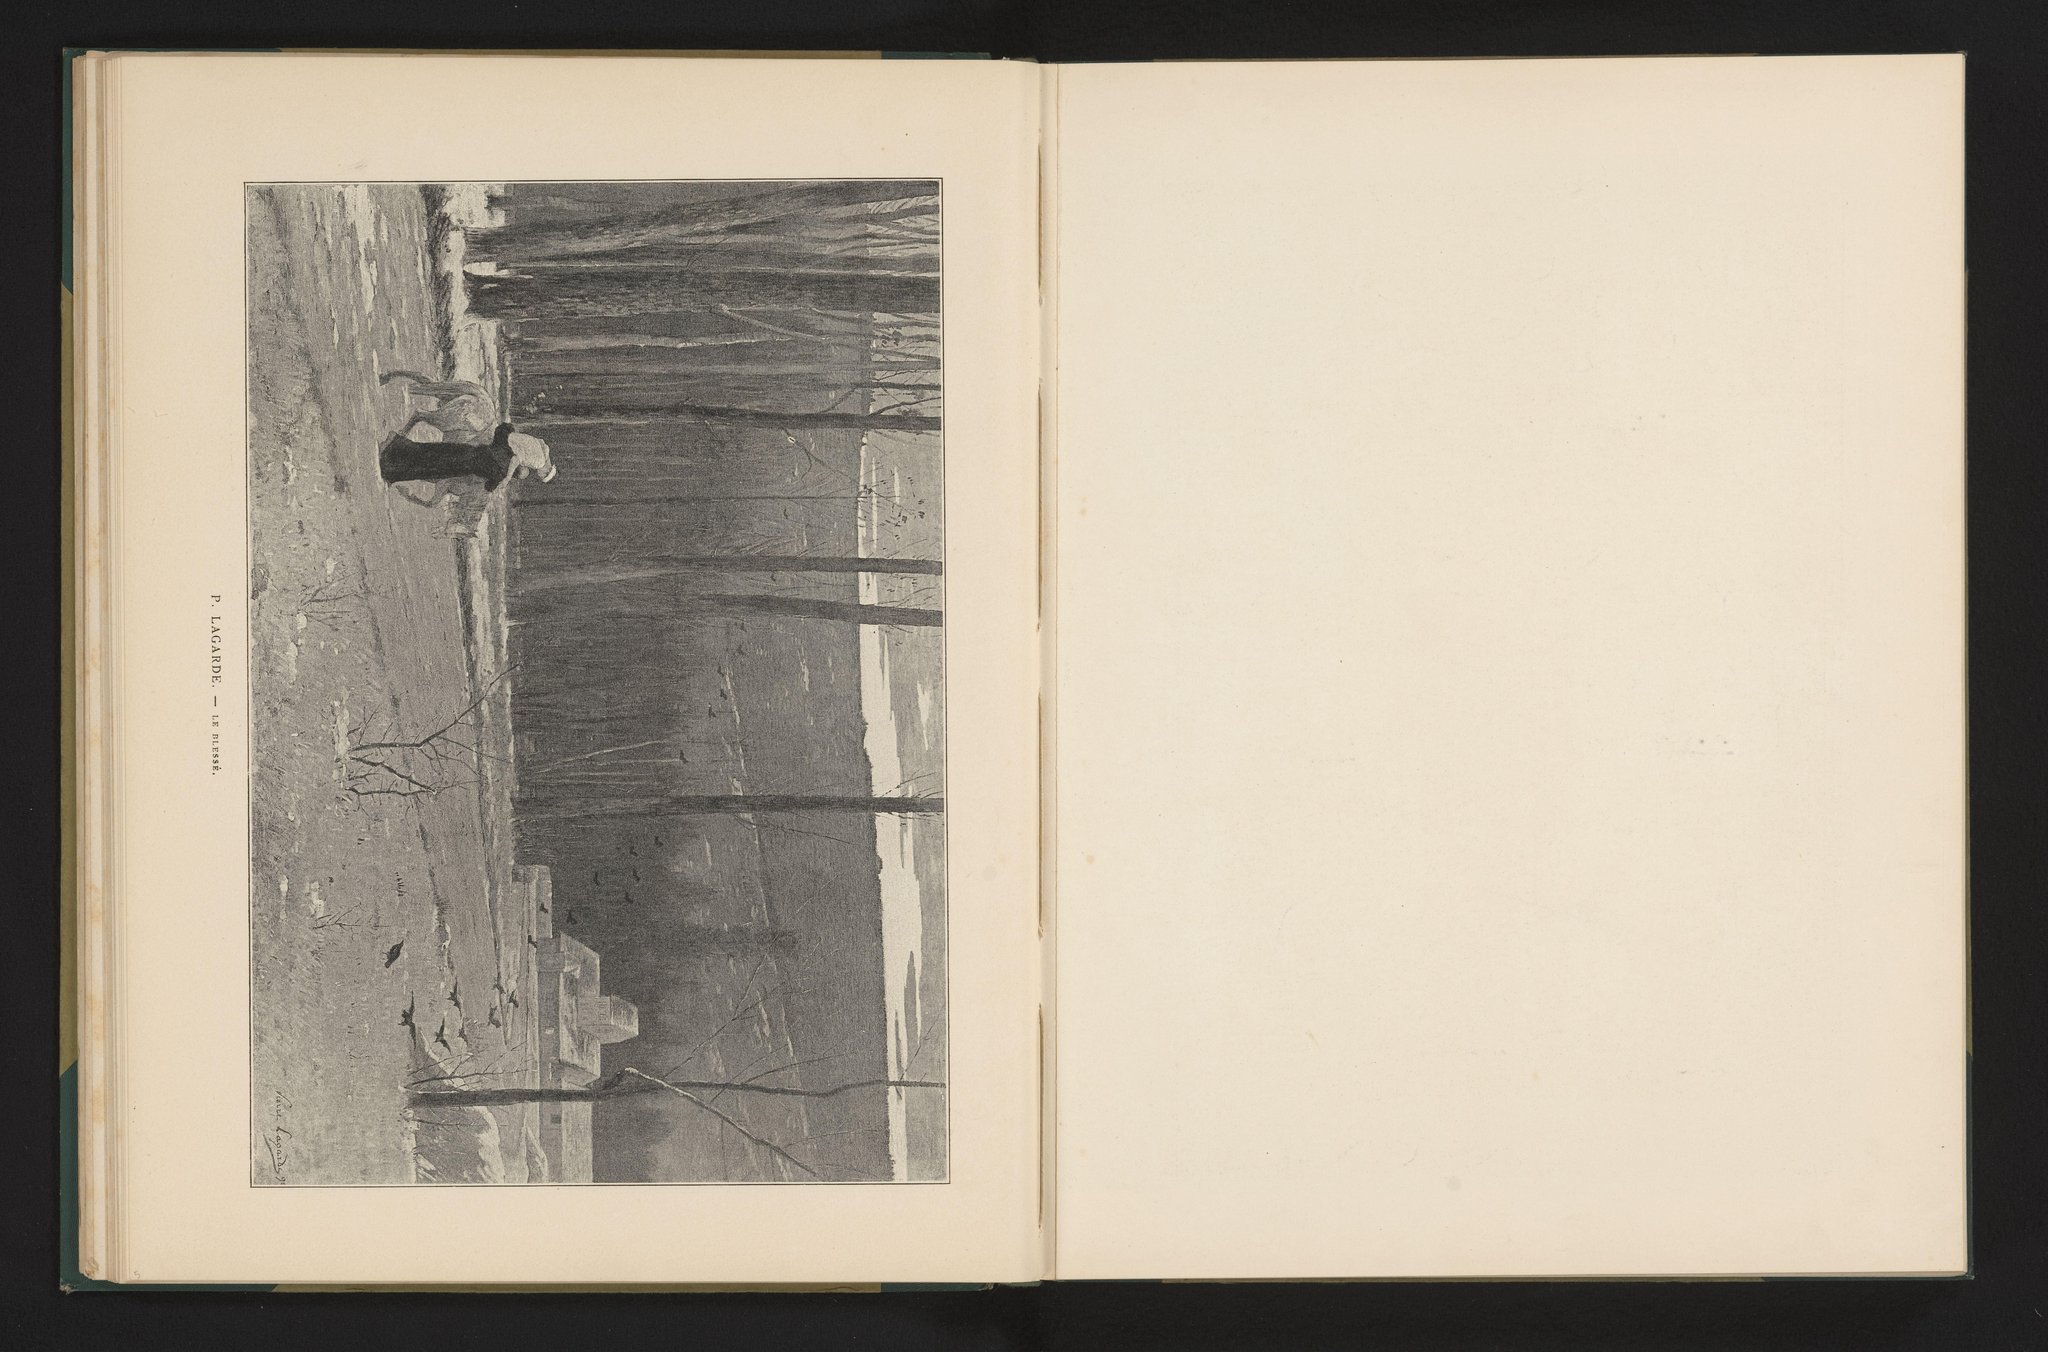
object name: photomechanical print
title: Le blessé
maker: Anonymous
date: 1885-1901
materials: paper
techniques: autotype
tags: riding a horse, ass, or mule; rider, horseman, landscapes in the temperate zone (+ landscape with figures, staffage)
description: Tweede prent na pagina 46 van Figaro-Salon.